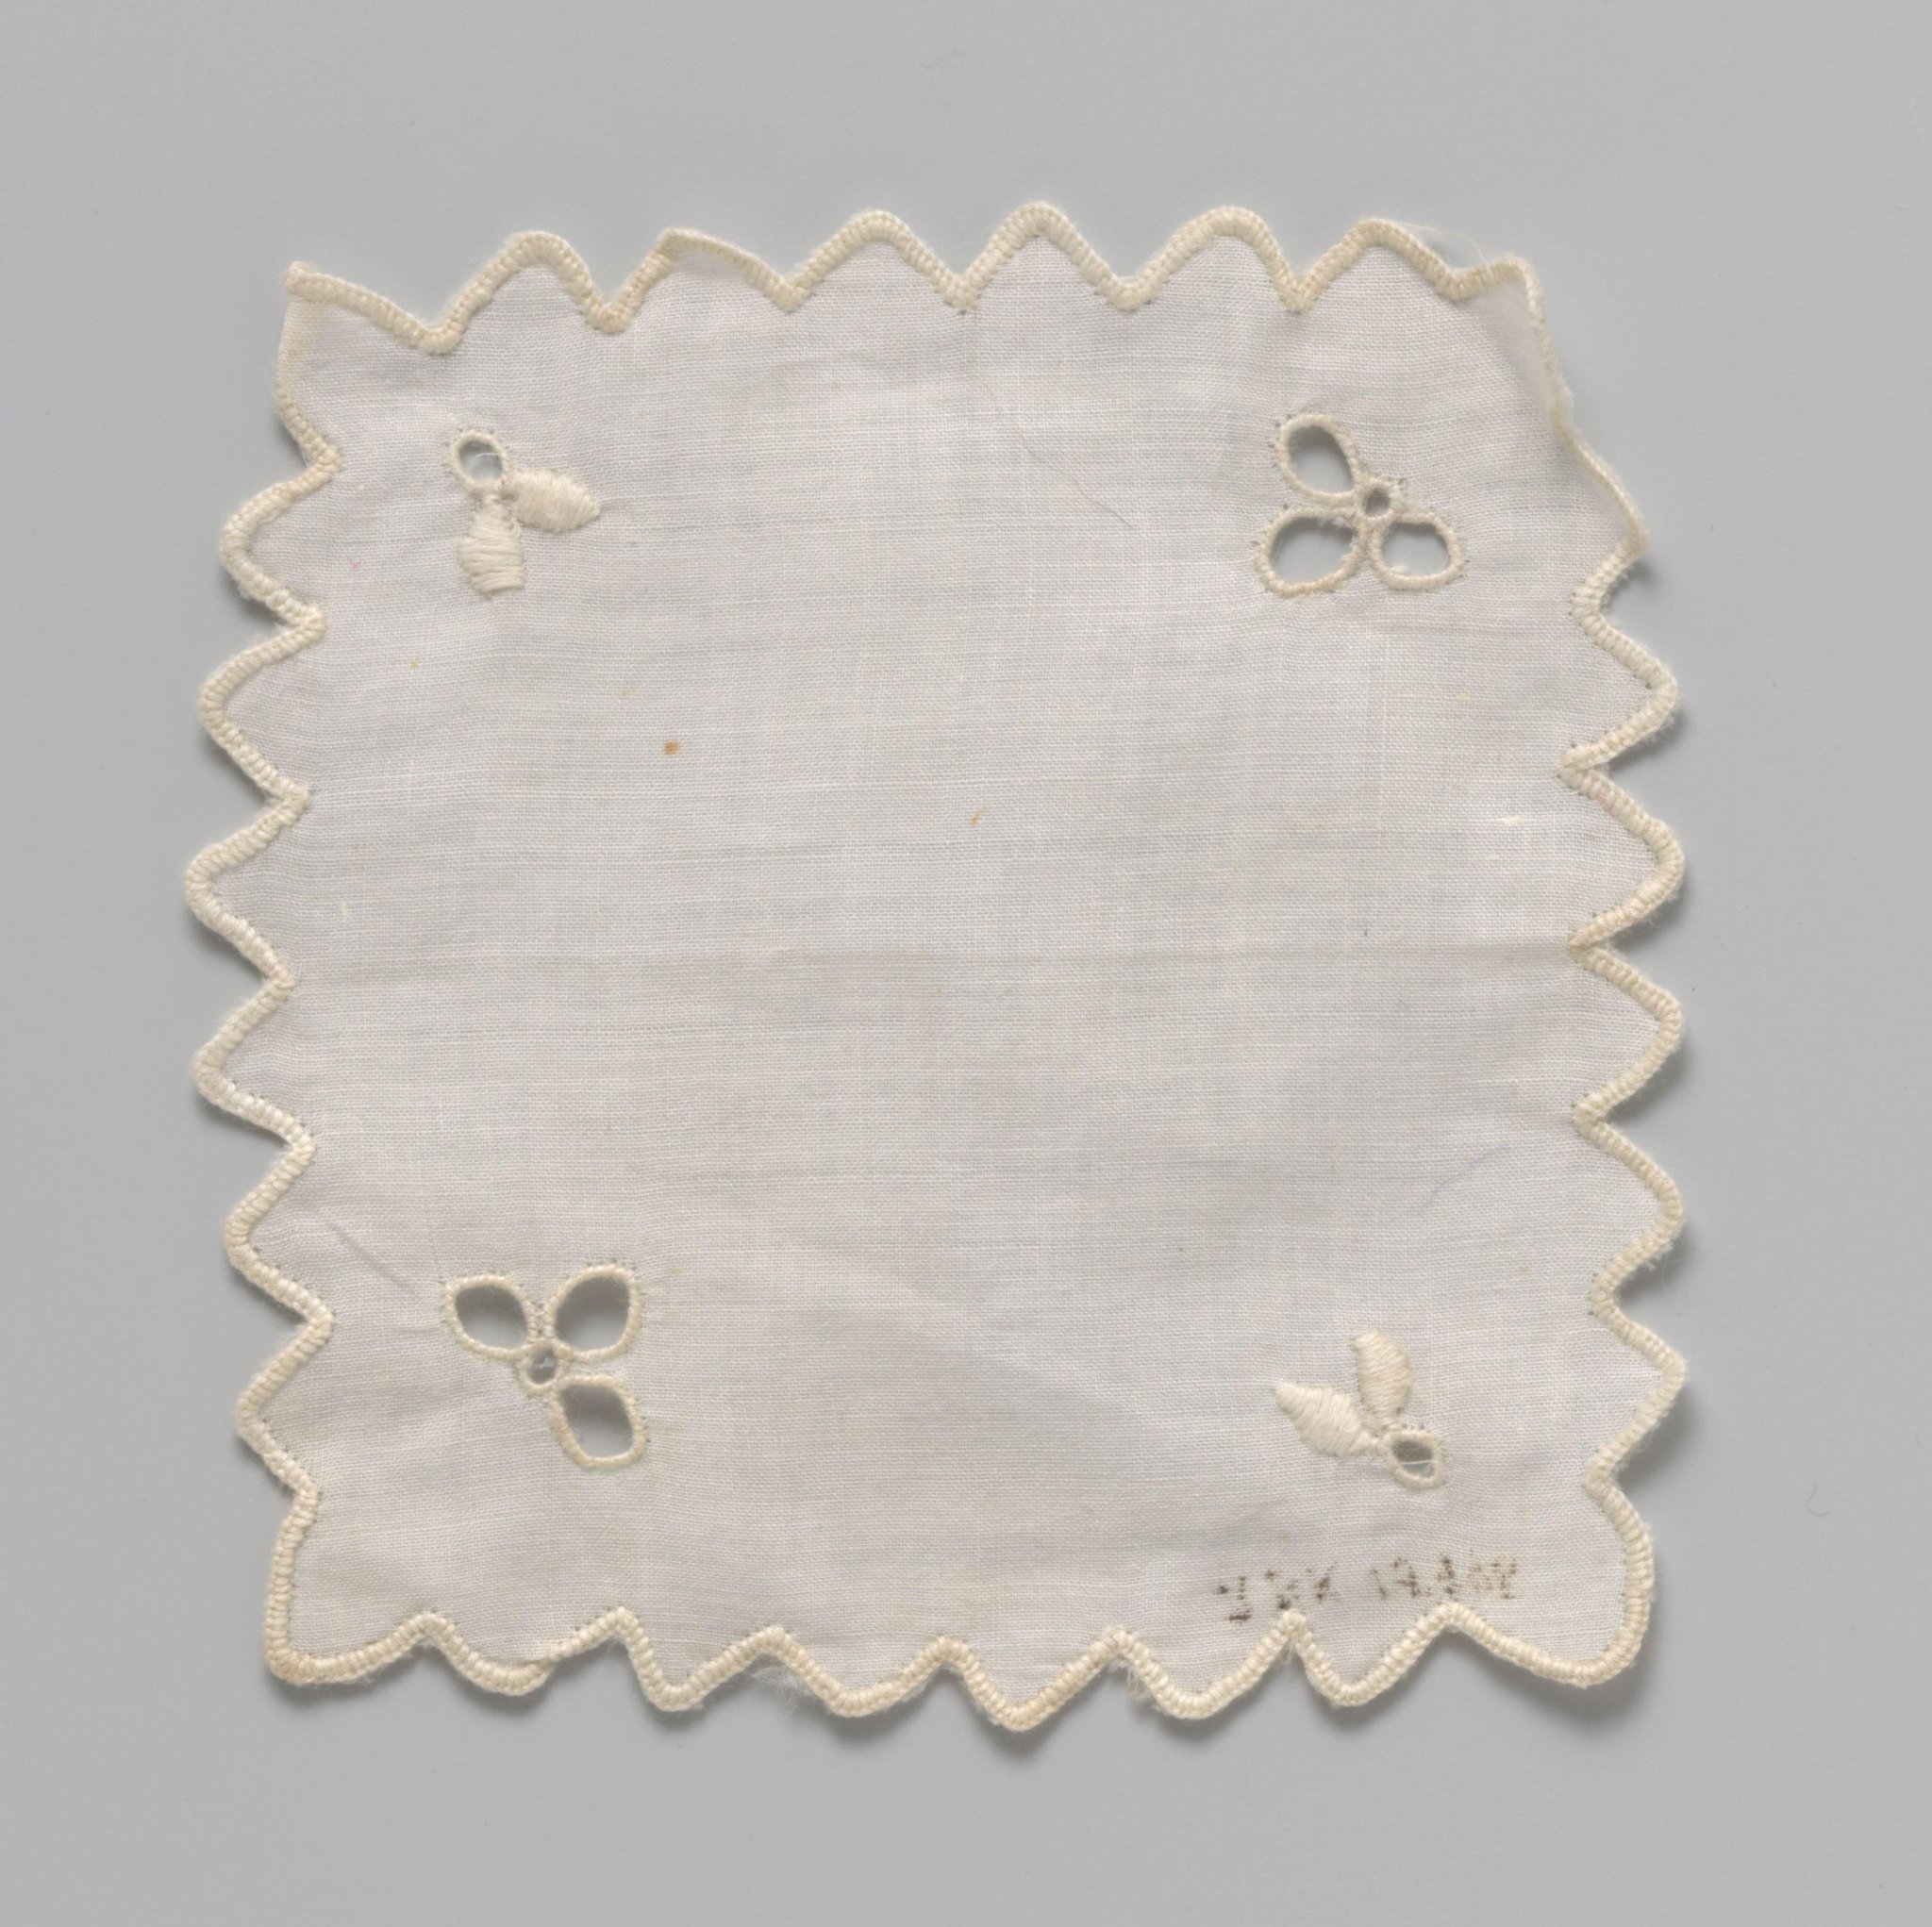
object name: cloth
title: Geschulpte vierkante witte doek met witwerk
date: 1836-1898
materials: textile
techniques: embroidery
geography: netherlands